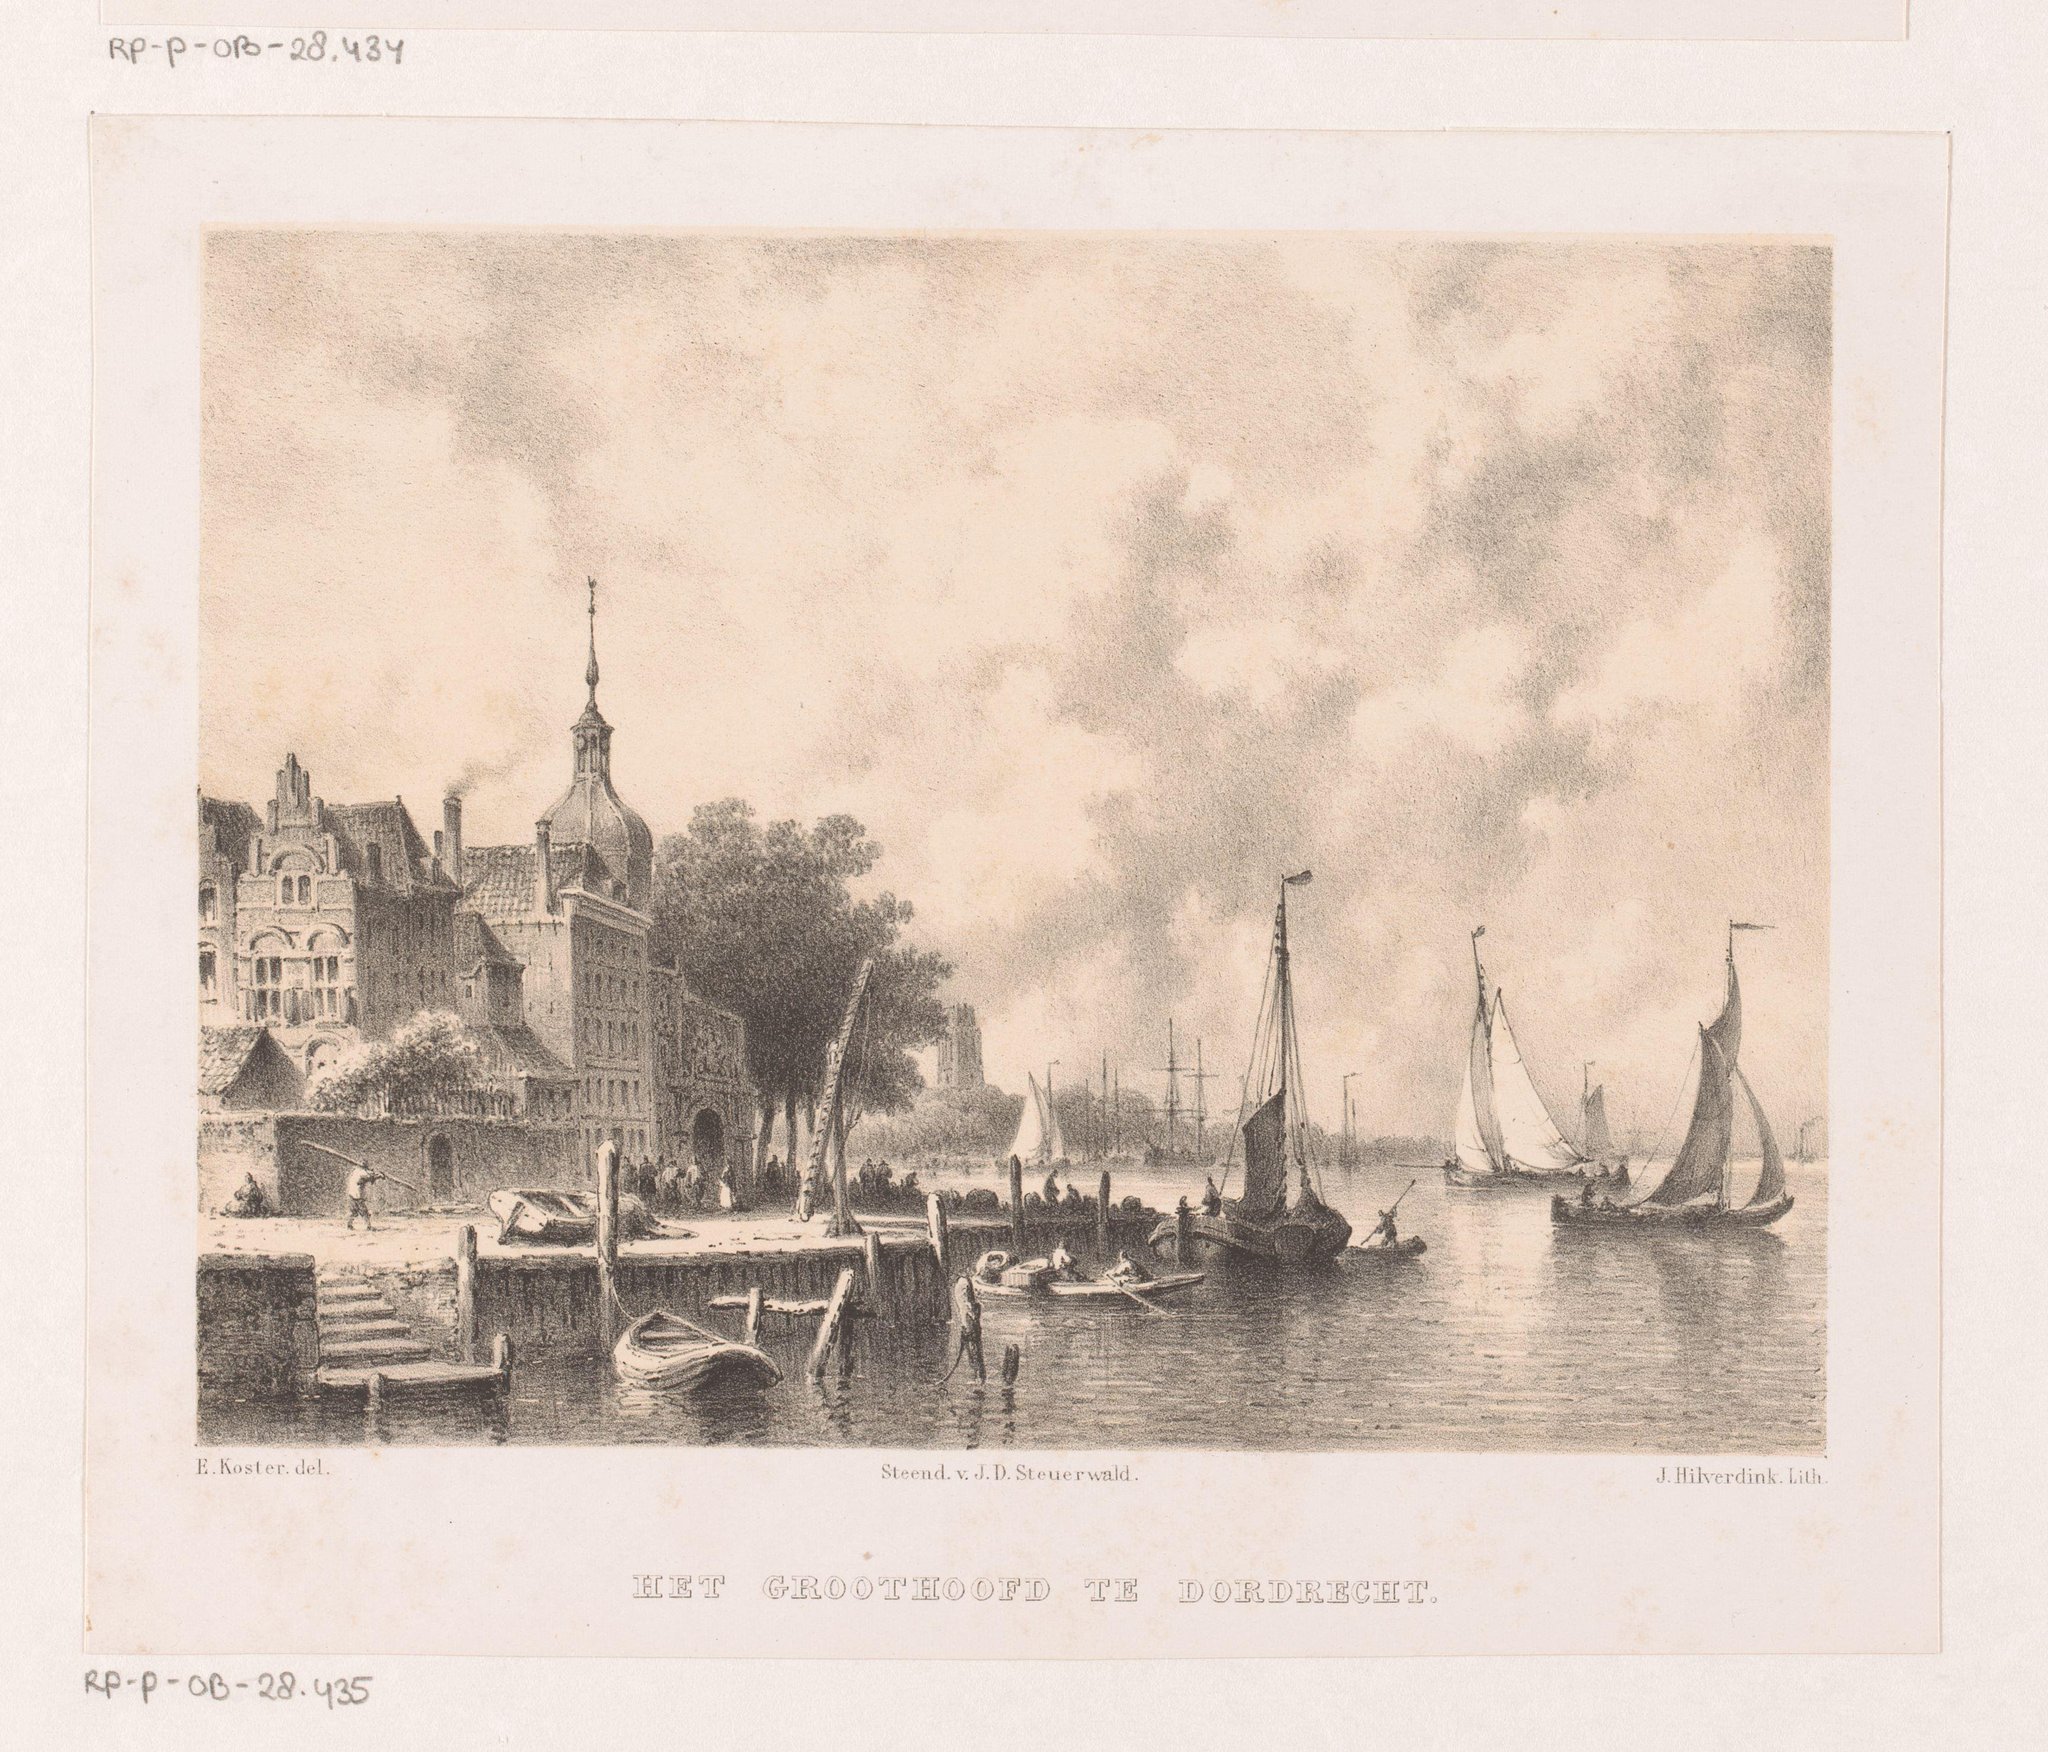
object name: print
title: Gezicht op Dordrecht met de Groothoofdspoort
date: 1858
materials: paper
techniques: tone lithography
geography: amsterdam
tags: city-gate (+ city(-scape) with figures, staffage), dordrecht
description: Deze prent komt uit: Koster, E. 'E. Koster's schetsboek: Nederlandsche Stads- en Havengezichten, uitgegeven onder medewerking van de maatschappij Arti et Amicitiae, Amsterdam, F. Buffa en Zn., e.a.' Amsterdam 1858.